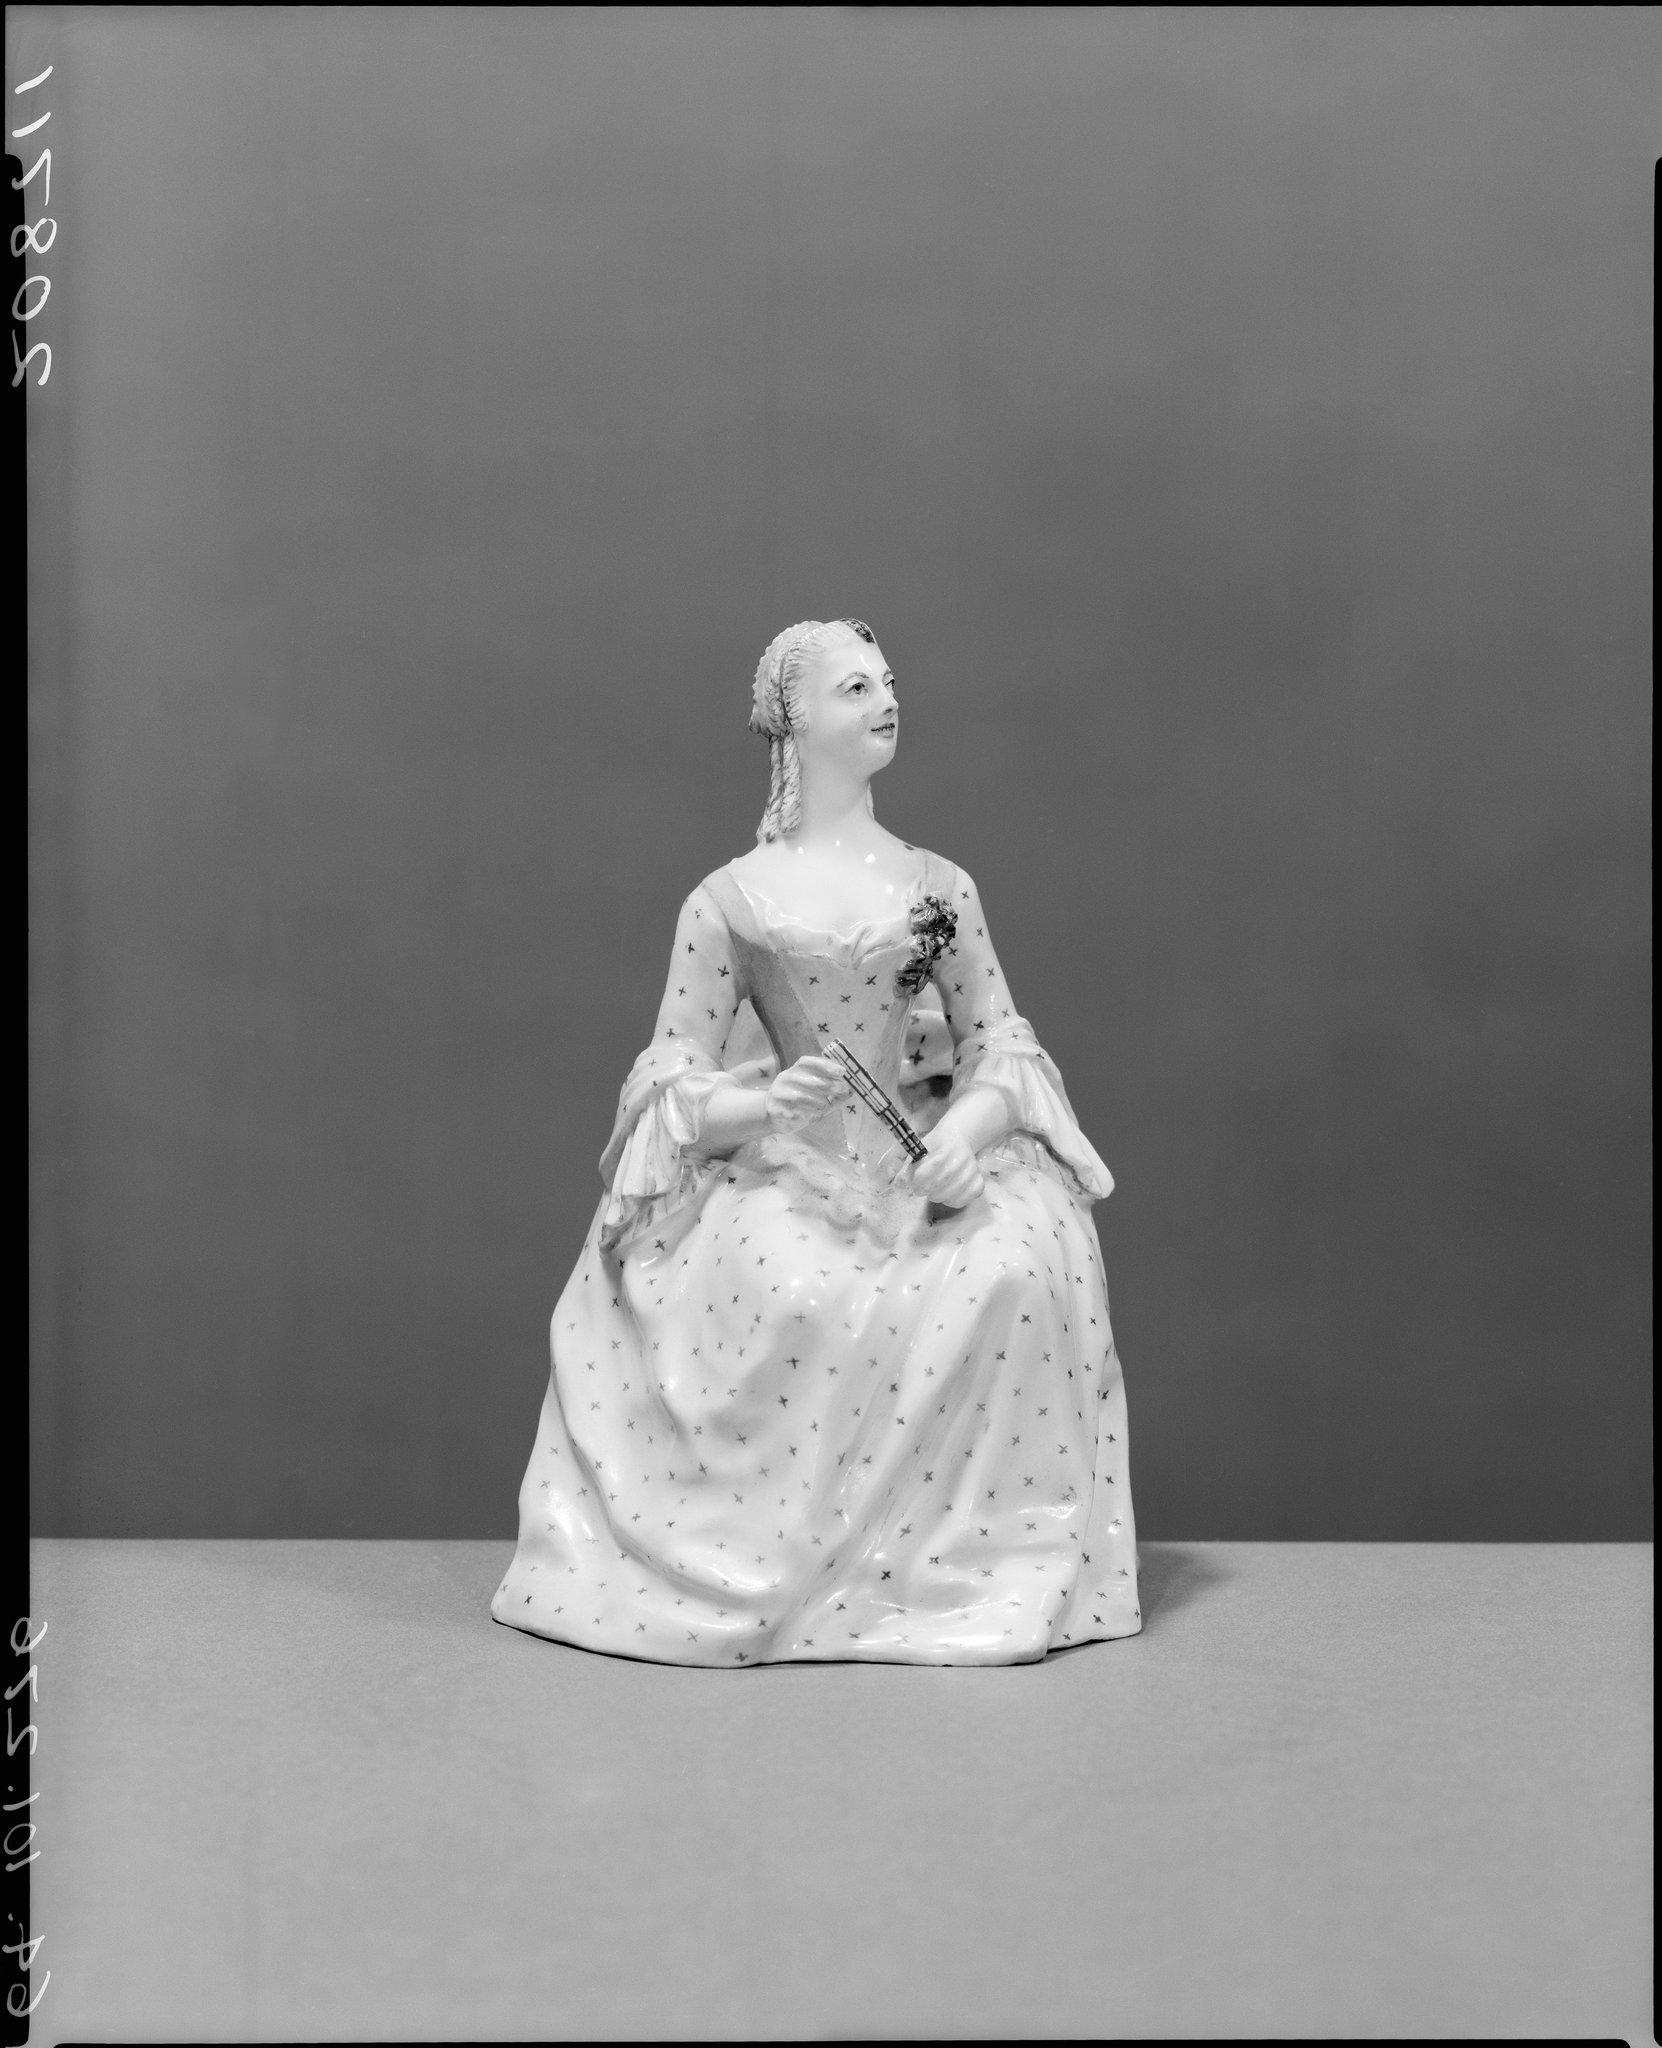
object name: figure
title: Seated woman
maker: imperial porcelain manufactory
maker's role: manufactory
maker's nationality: austrian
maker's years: 1744-1864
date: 1744-1749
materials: hard paste porcelain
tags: women